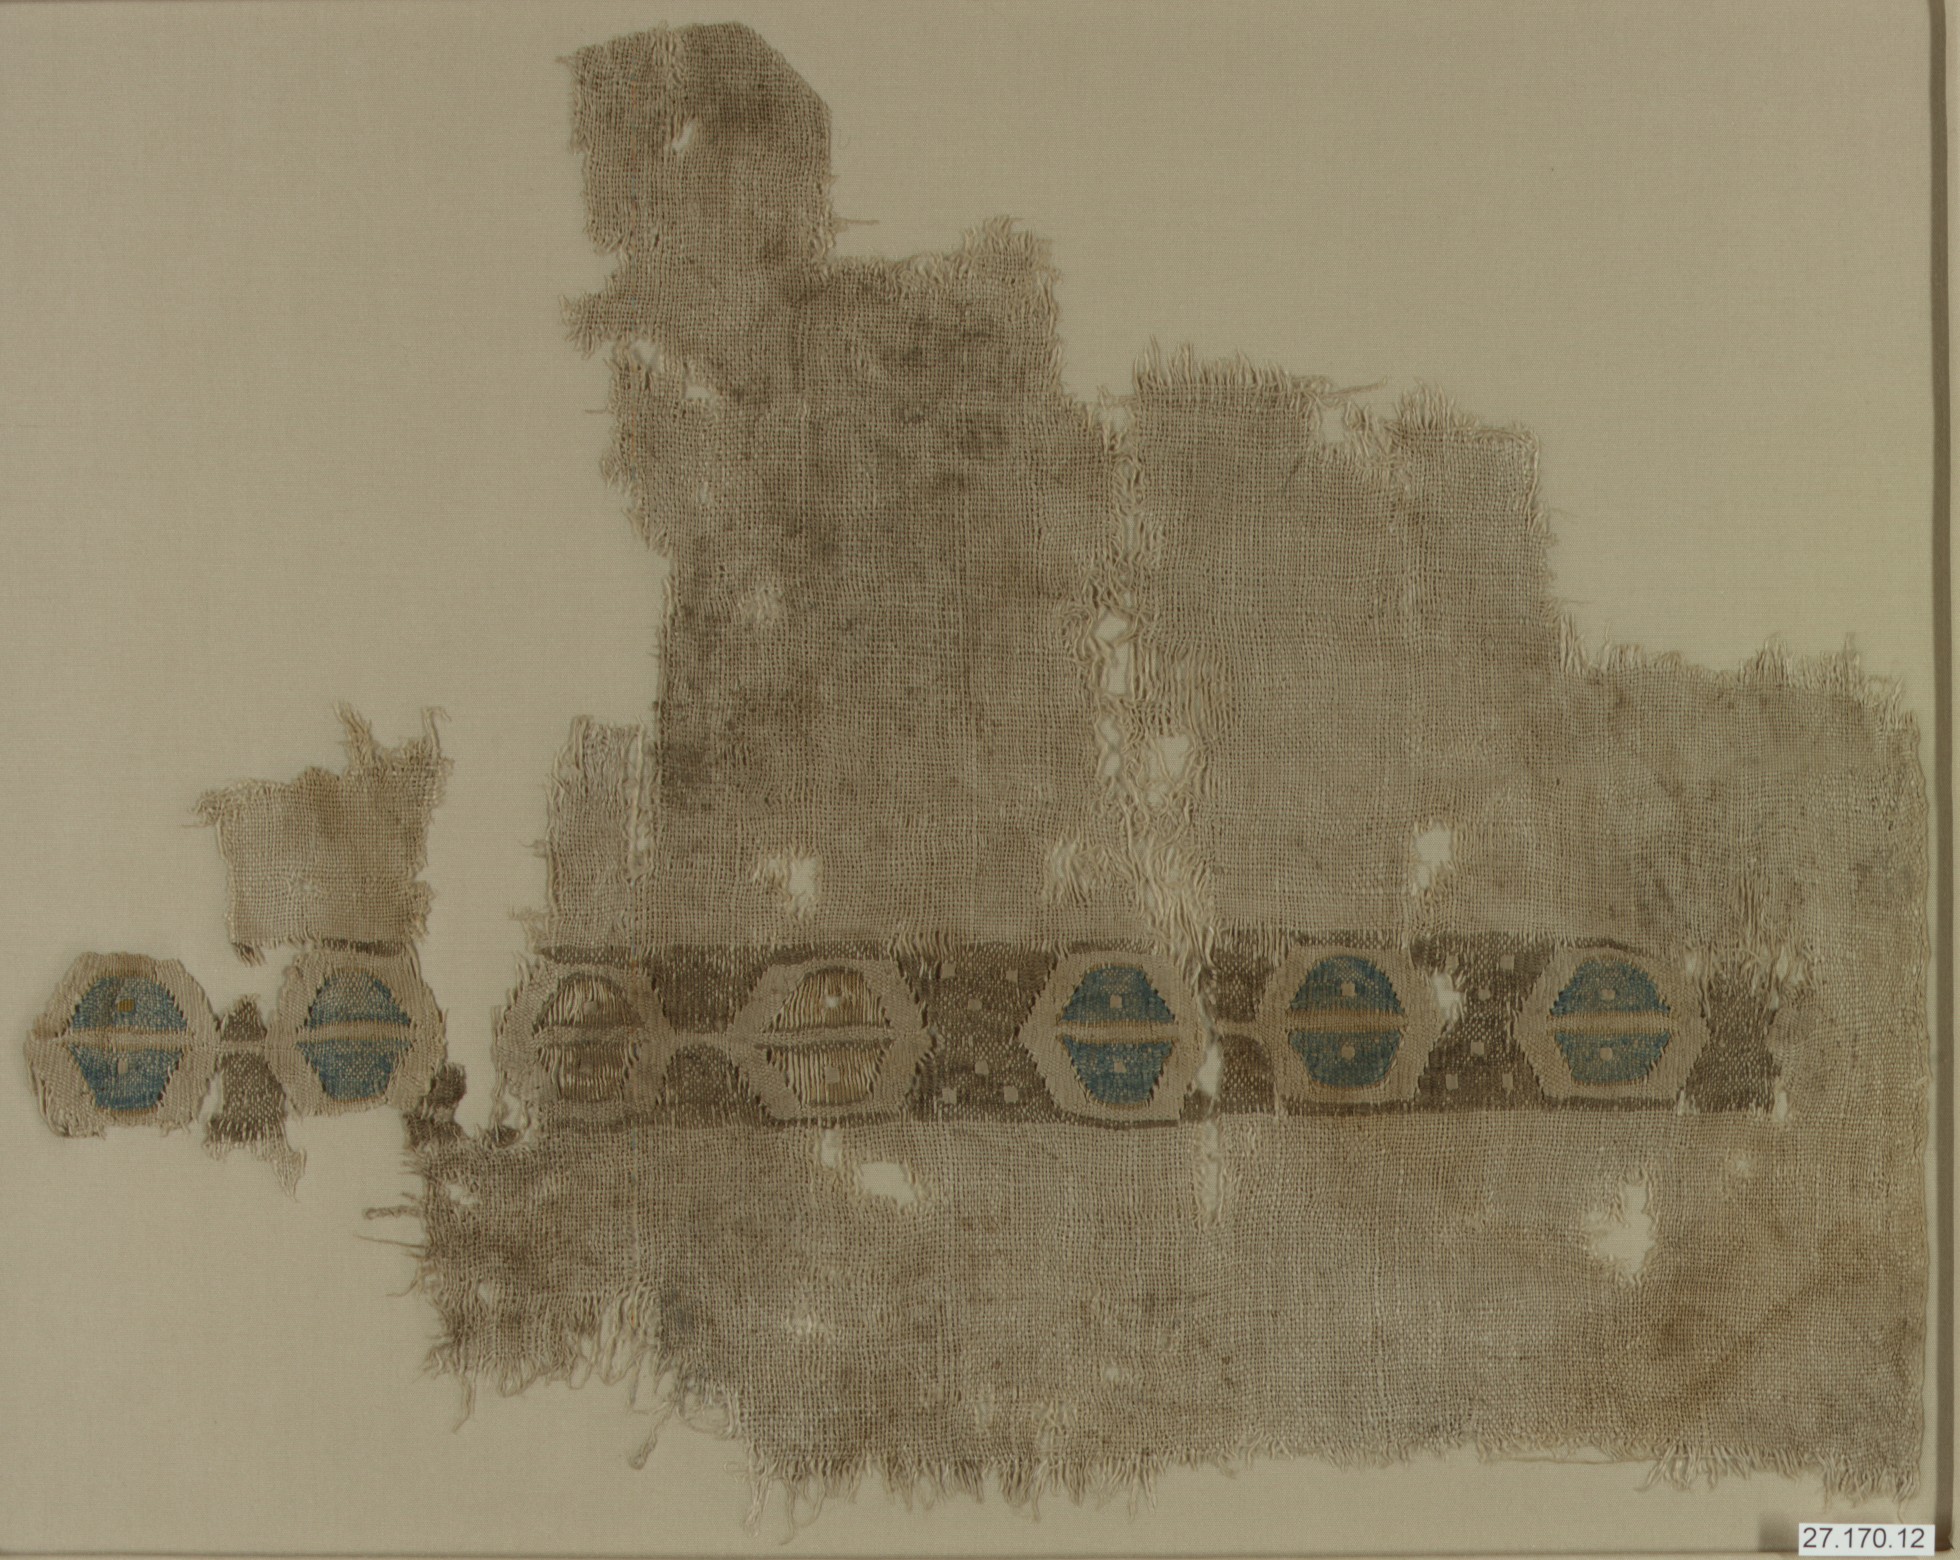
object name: textile fragment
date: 801-900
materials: linen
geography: egypt